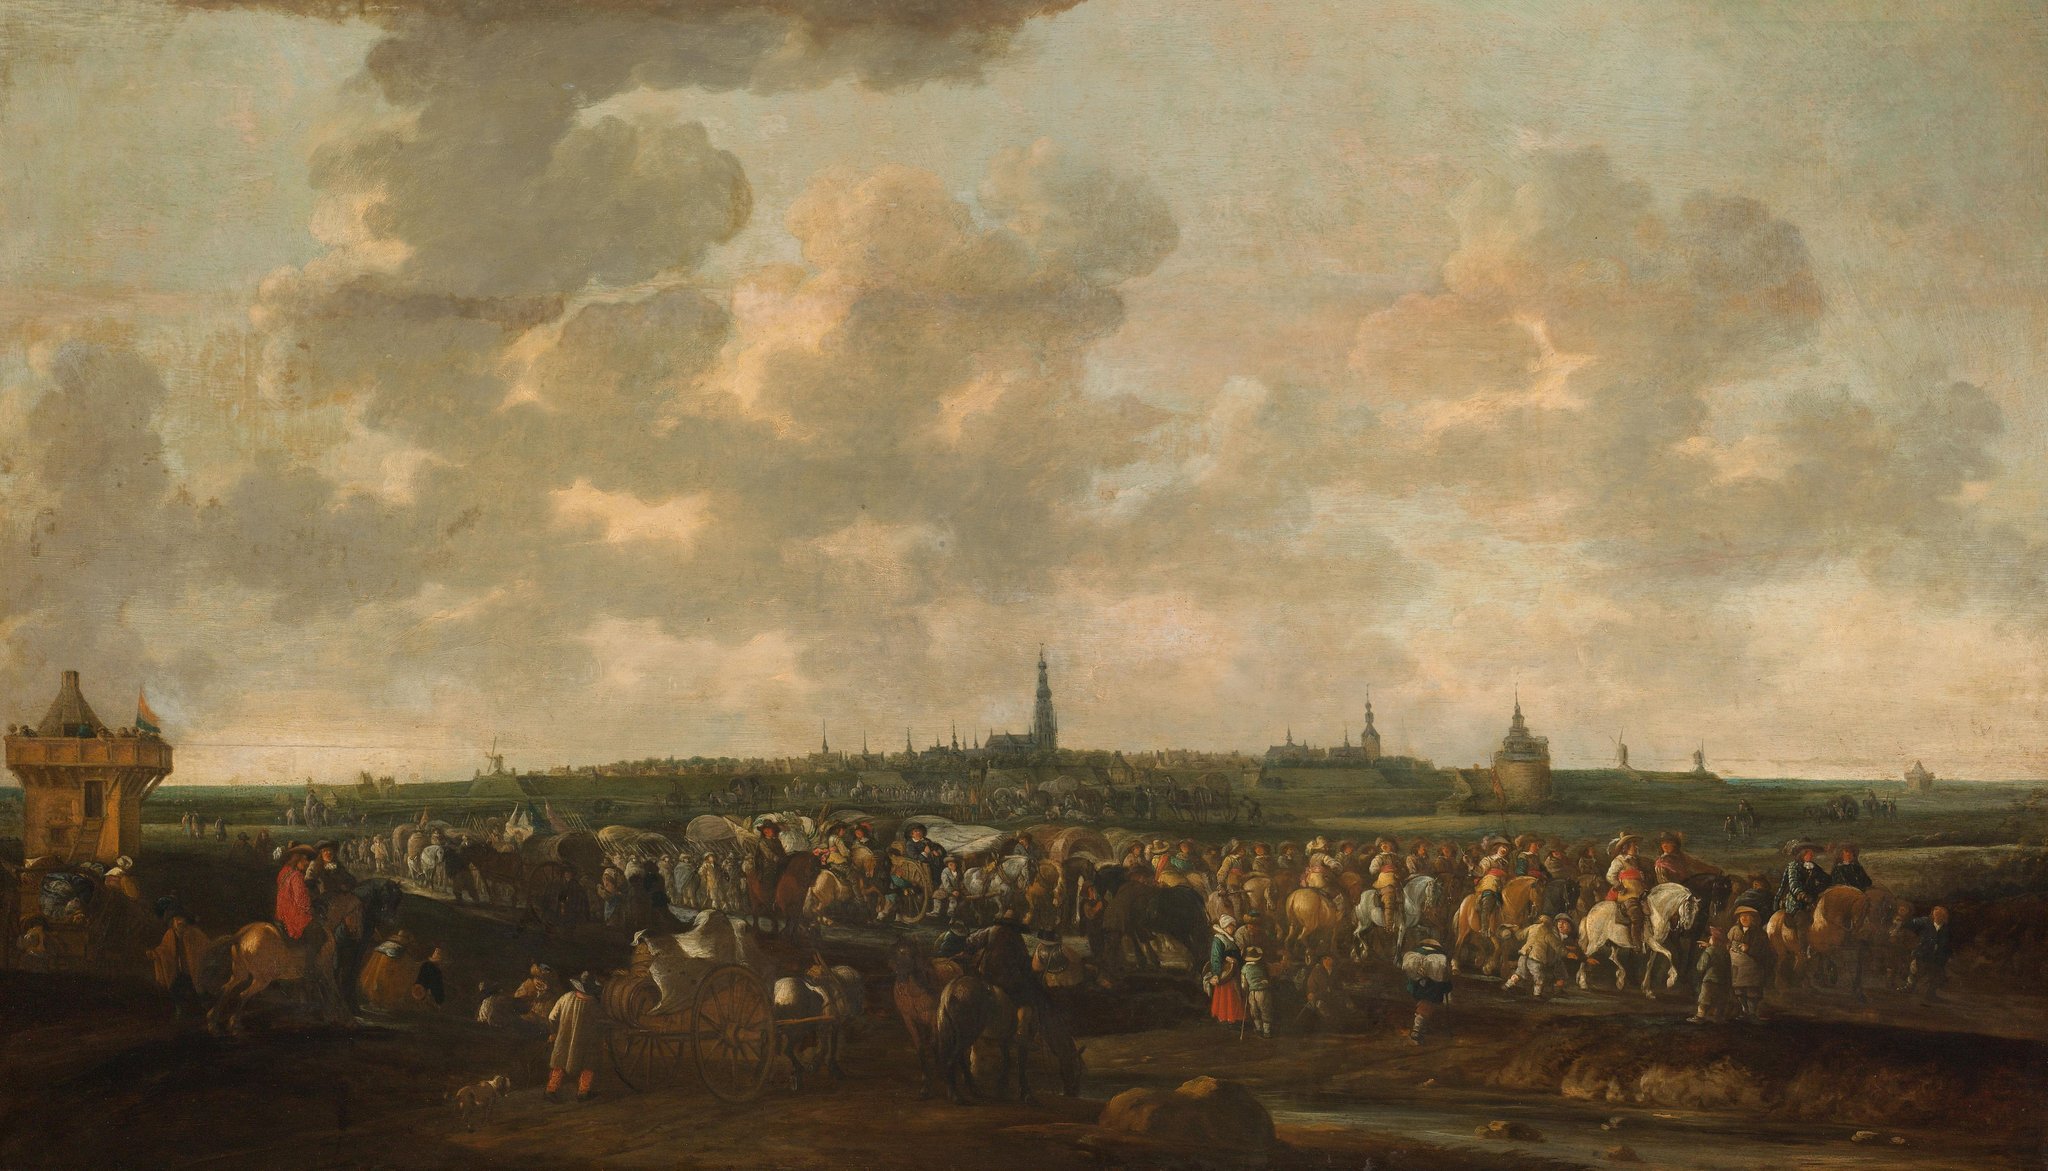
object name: painting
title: Departure of Spanish Occupation Troops from Breda, October 10, 1637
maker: hendrick de meijer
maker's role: painter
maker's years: 1620-1698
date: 1647-1683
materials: panel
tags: liberation of besieged city, after the battle, siege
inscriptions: signature and date: ‘H. de Meyer f. 16..’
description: Hendrik de Meyer (active 1637 - 1683). The Departure of the Spanish Occupying Force from Breda on 10 October 1637. Signed 1663 (?). In original gilt lime frame.